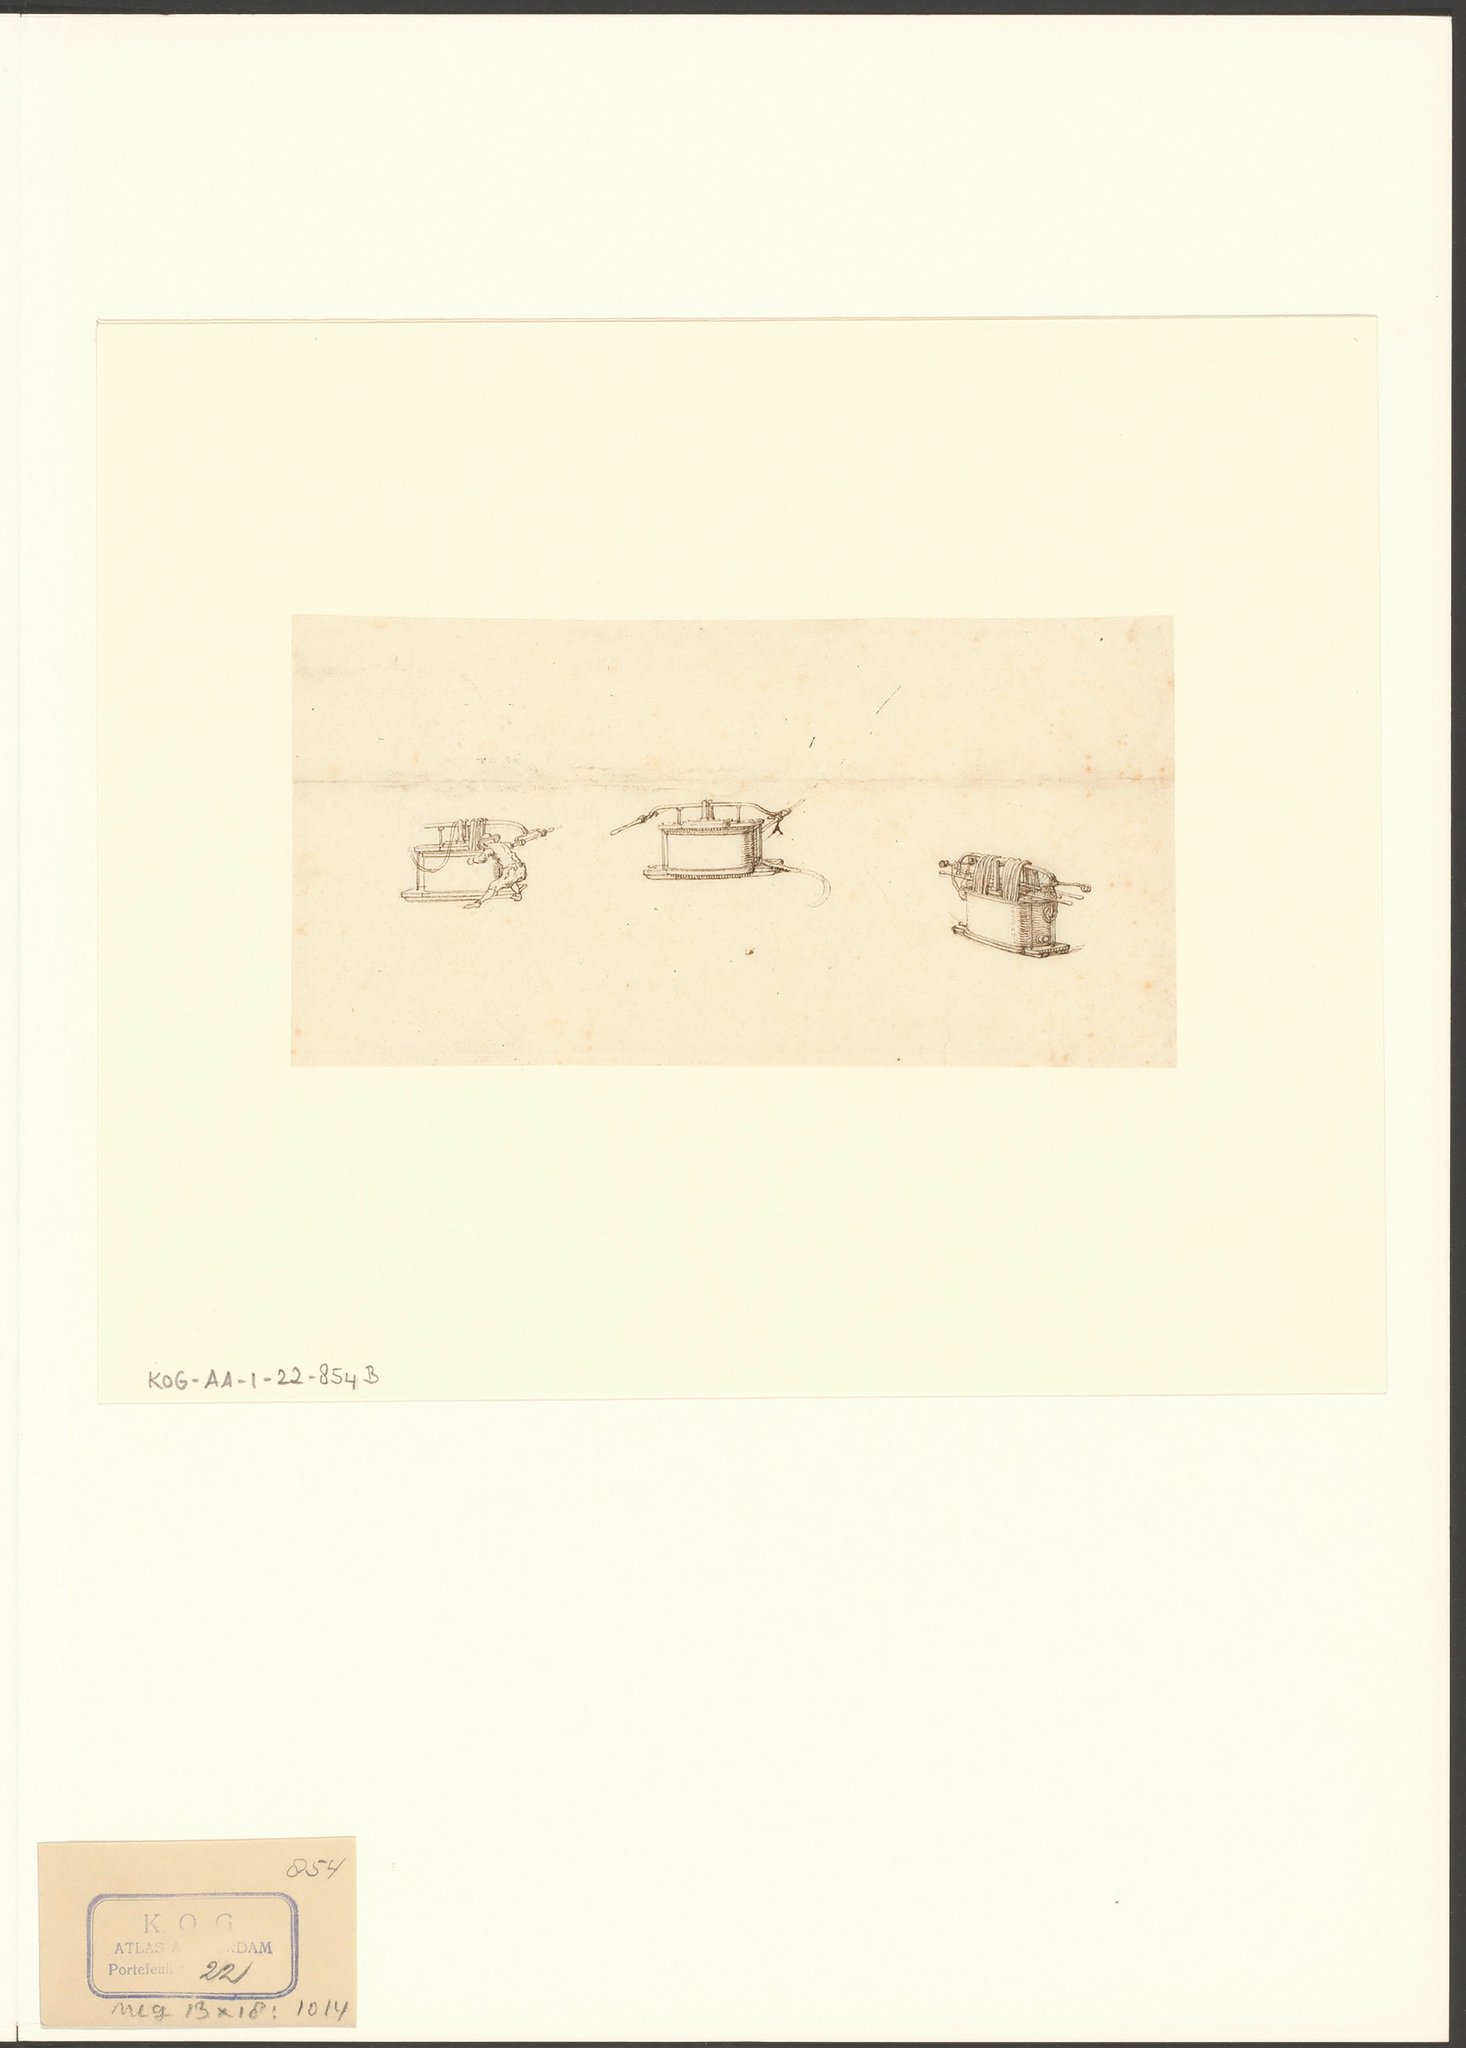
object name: drawing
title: Compositie met drie brandweerpompen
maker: jan van der heyden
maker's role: draughtsman, painter, print maker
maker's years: 1637-1712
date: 1647-1690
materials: ink, paper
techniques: pen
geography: amsterdam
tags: pump (fire-extinguishing equipment)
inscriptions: collector's mark: ‘22’ Lugt 1641b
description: Ontwerptekening voor illustraties uit: Heyden, Jan van der. Beschryving der nieuwlyks uitgevonden en geoctrojeerde slang-brandspuiten, en haare wyze van brand-blussen (...). Amsterdam: Jan Rieuwertsz (II), 1690.